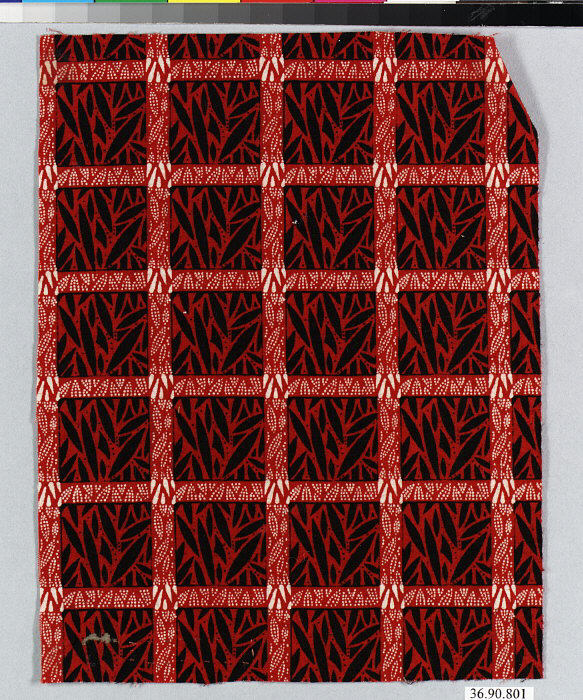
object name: piece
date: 1867-1900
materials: cotton